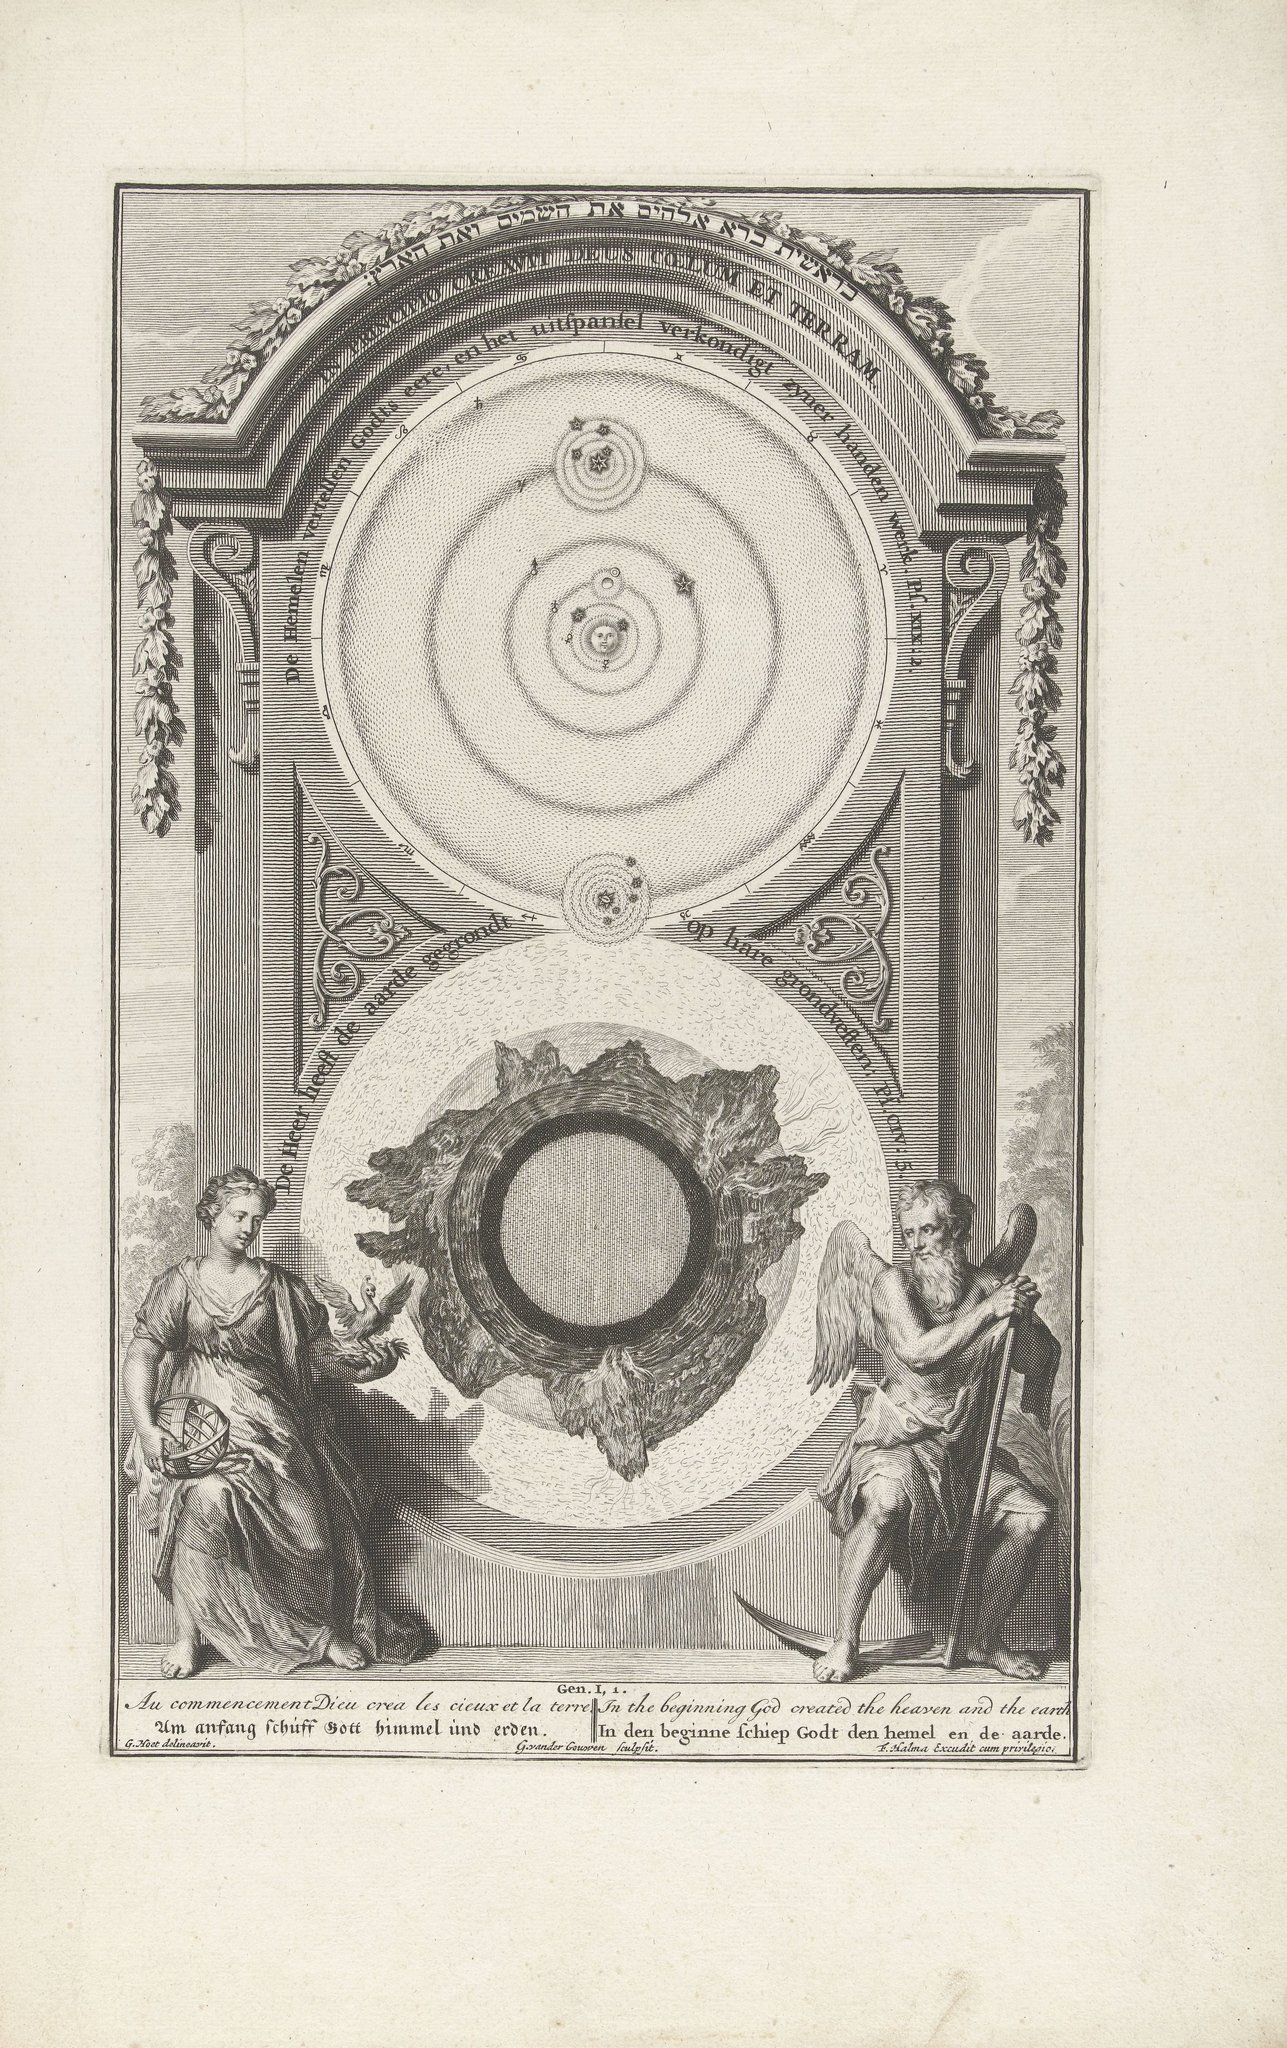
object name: print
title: Schepping van de wereld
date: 1728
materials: paper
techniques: engraving, etching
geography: amsterdam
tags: globe, father time, man with wings and scythe, creation of sun, moon and stars, planets; planetary system, solar system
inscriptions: inscription: ‘utrechts Fundatie huijs’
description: De schepping van de wereld (Gen. 1:1). Een monument met twee voorstellingen. Boven een hemelkaart van het zonnestelsel. Onder de schepping van de aarde. Links van het monument een vrouw met een nest waarin een vogel staat in haar linkerhand. In haar rechterhand een globe. Links de gevleugelde Tijd met een zeis. De prent heeft een Frans, Engels, Duits en Nederlands onderschrift.